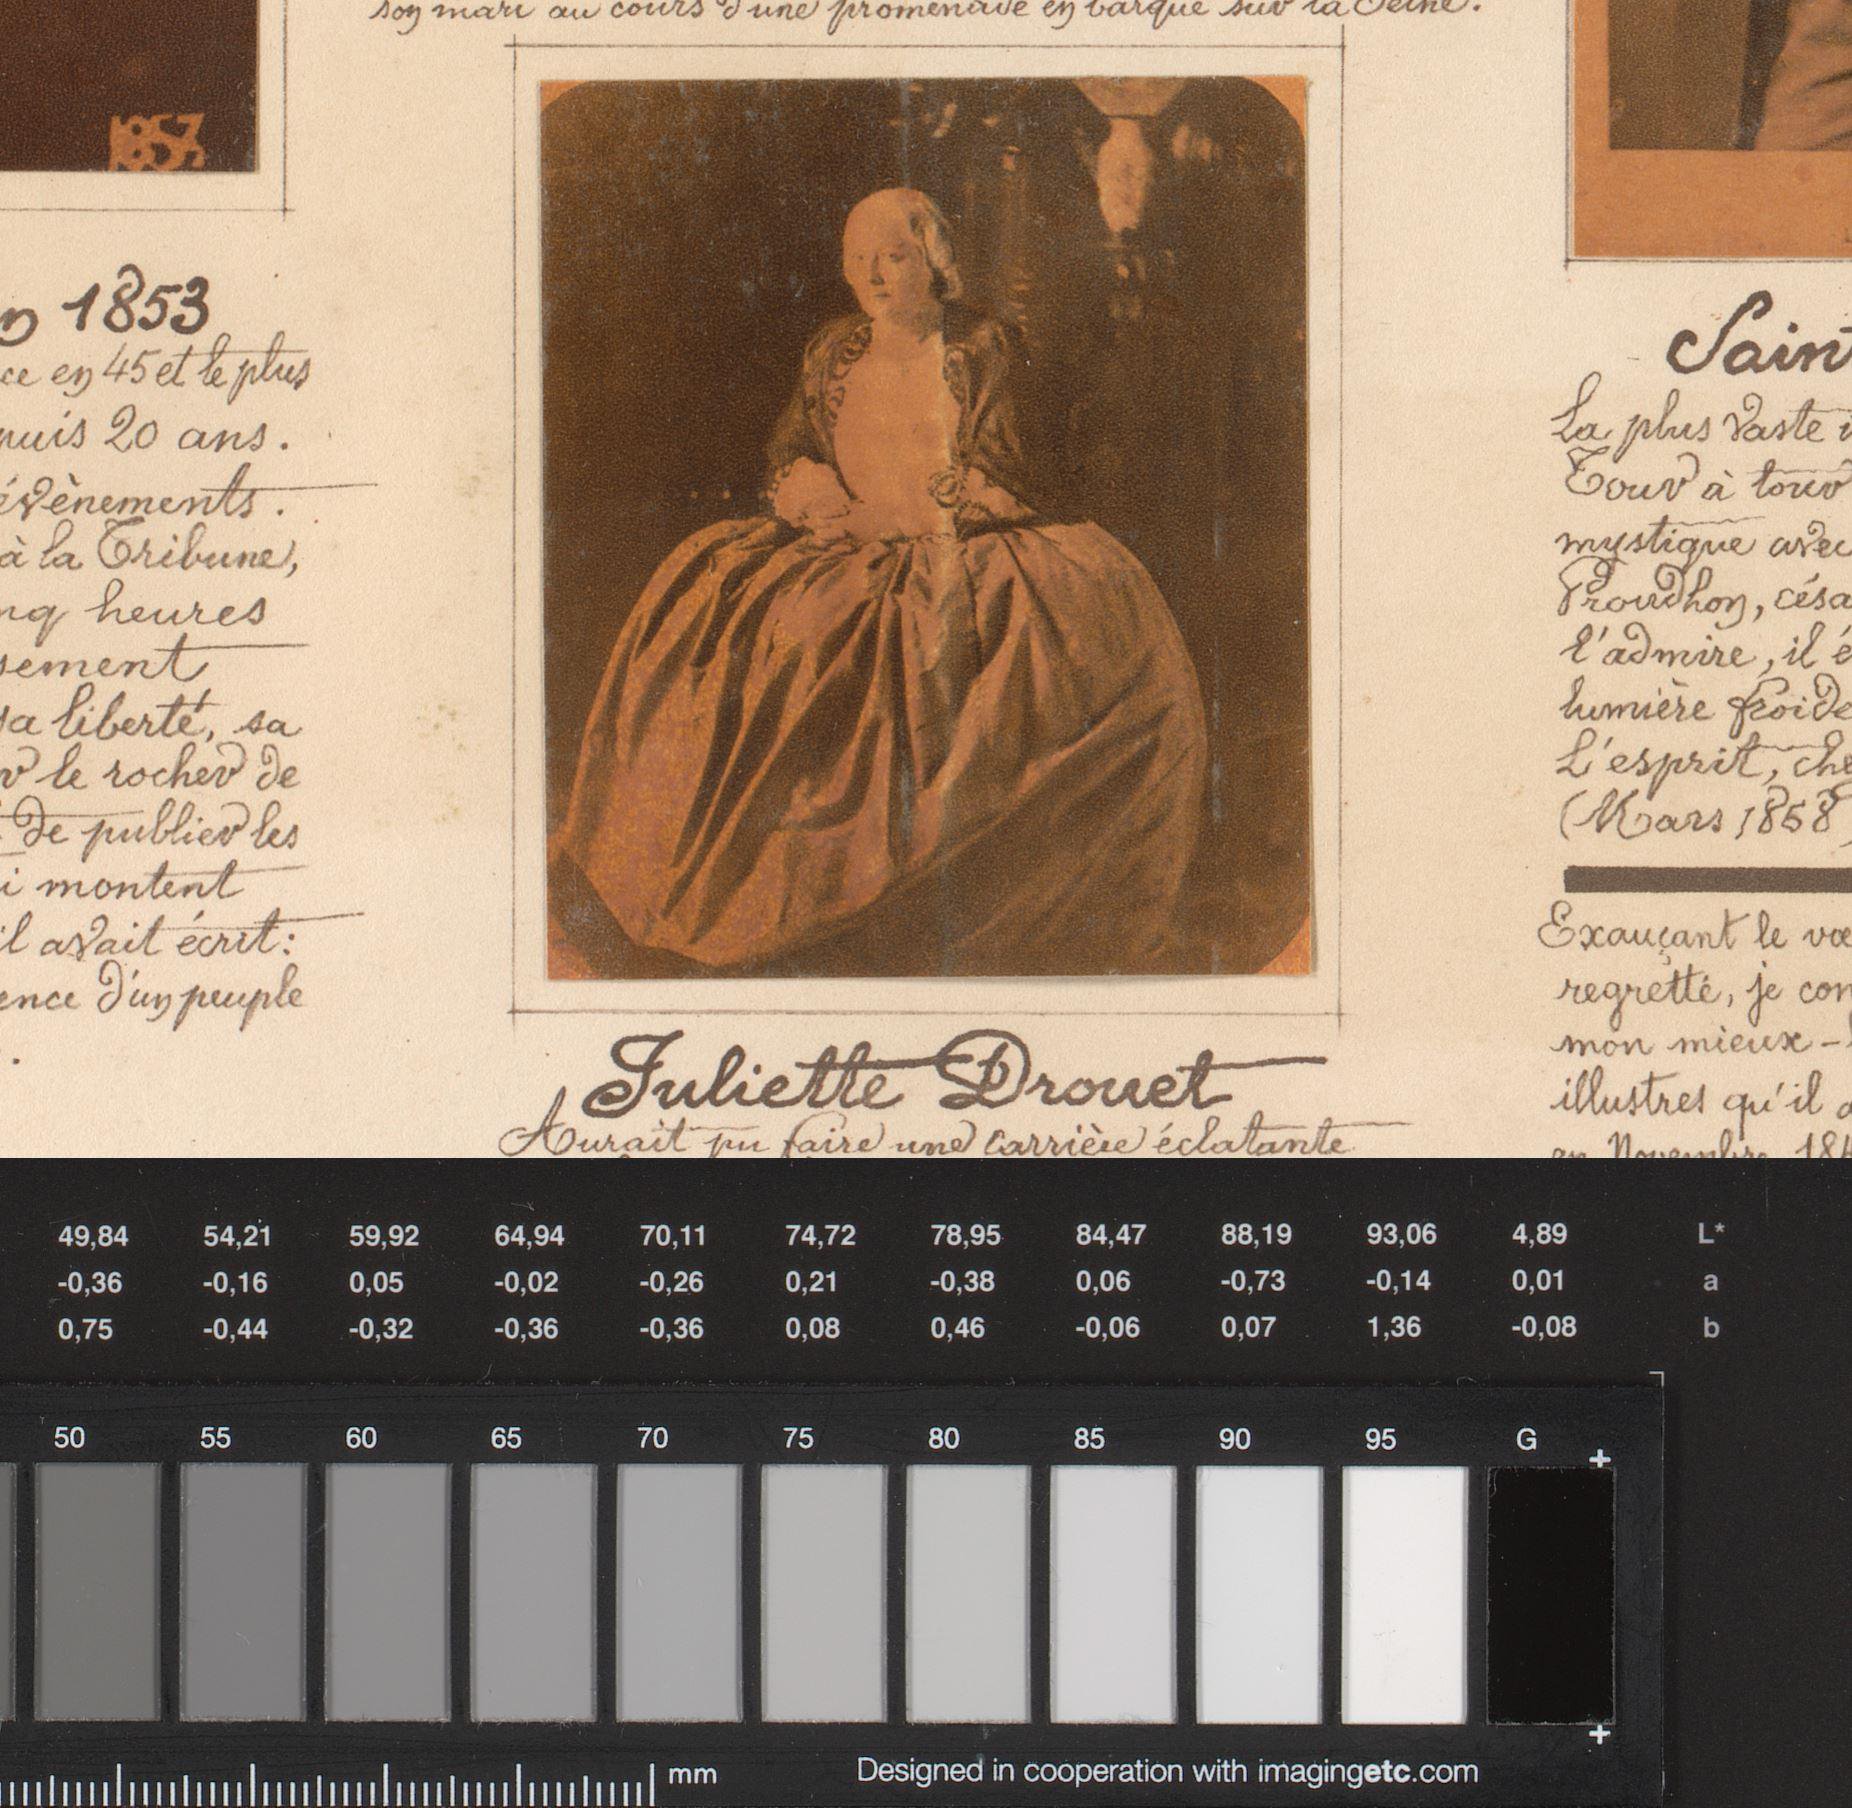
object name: photomechanical print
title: Juliette Drouet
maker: Anonymous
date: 1845-1853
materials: paper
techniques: rotogravure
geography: france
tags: portrait of actor, actress, france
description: Deze prent maakt deel uit van een album.